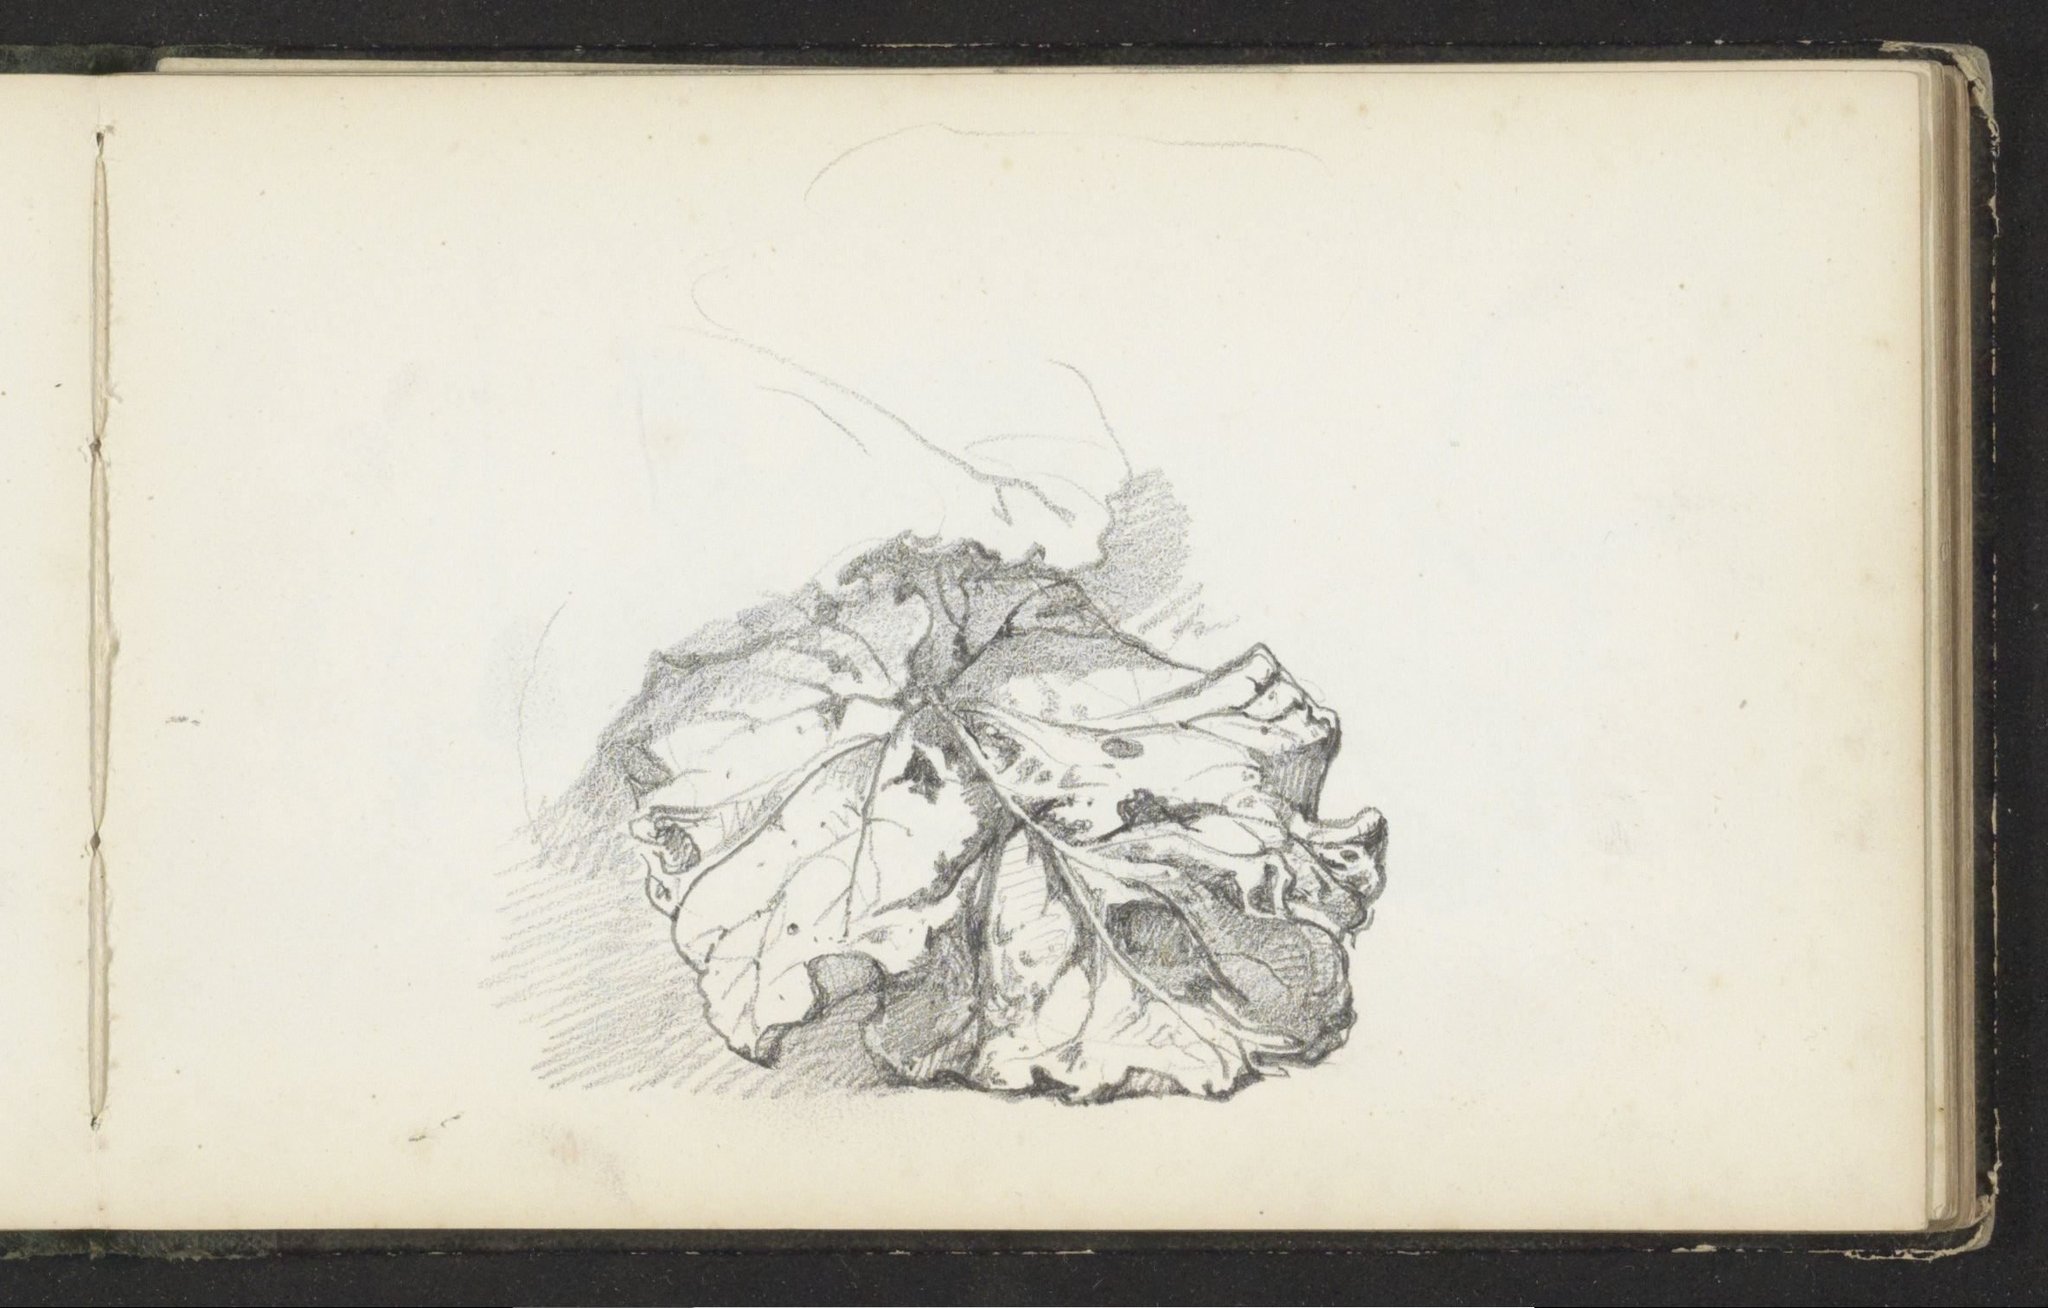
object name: sketchbook leaf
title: Blad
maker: maria vos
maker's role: draughtsman, painter, print maker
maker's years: 1824-1906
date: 1856-1870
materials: paper, pencil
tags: plants (in general) (+ leaf)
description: Blad 14 recto uit een schetsboek met 39 bladen.